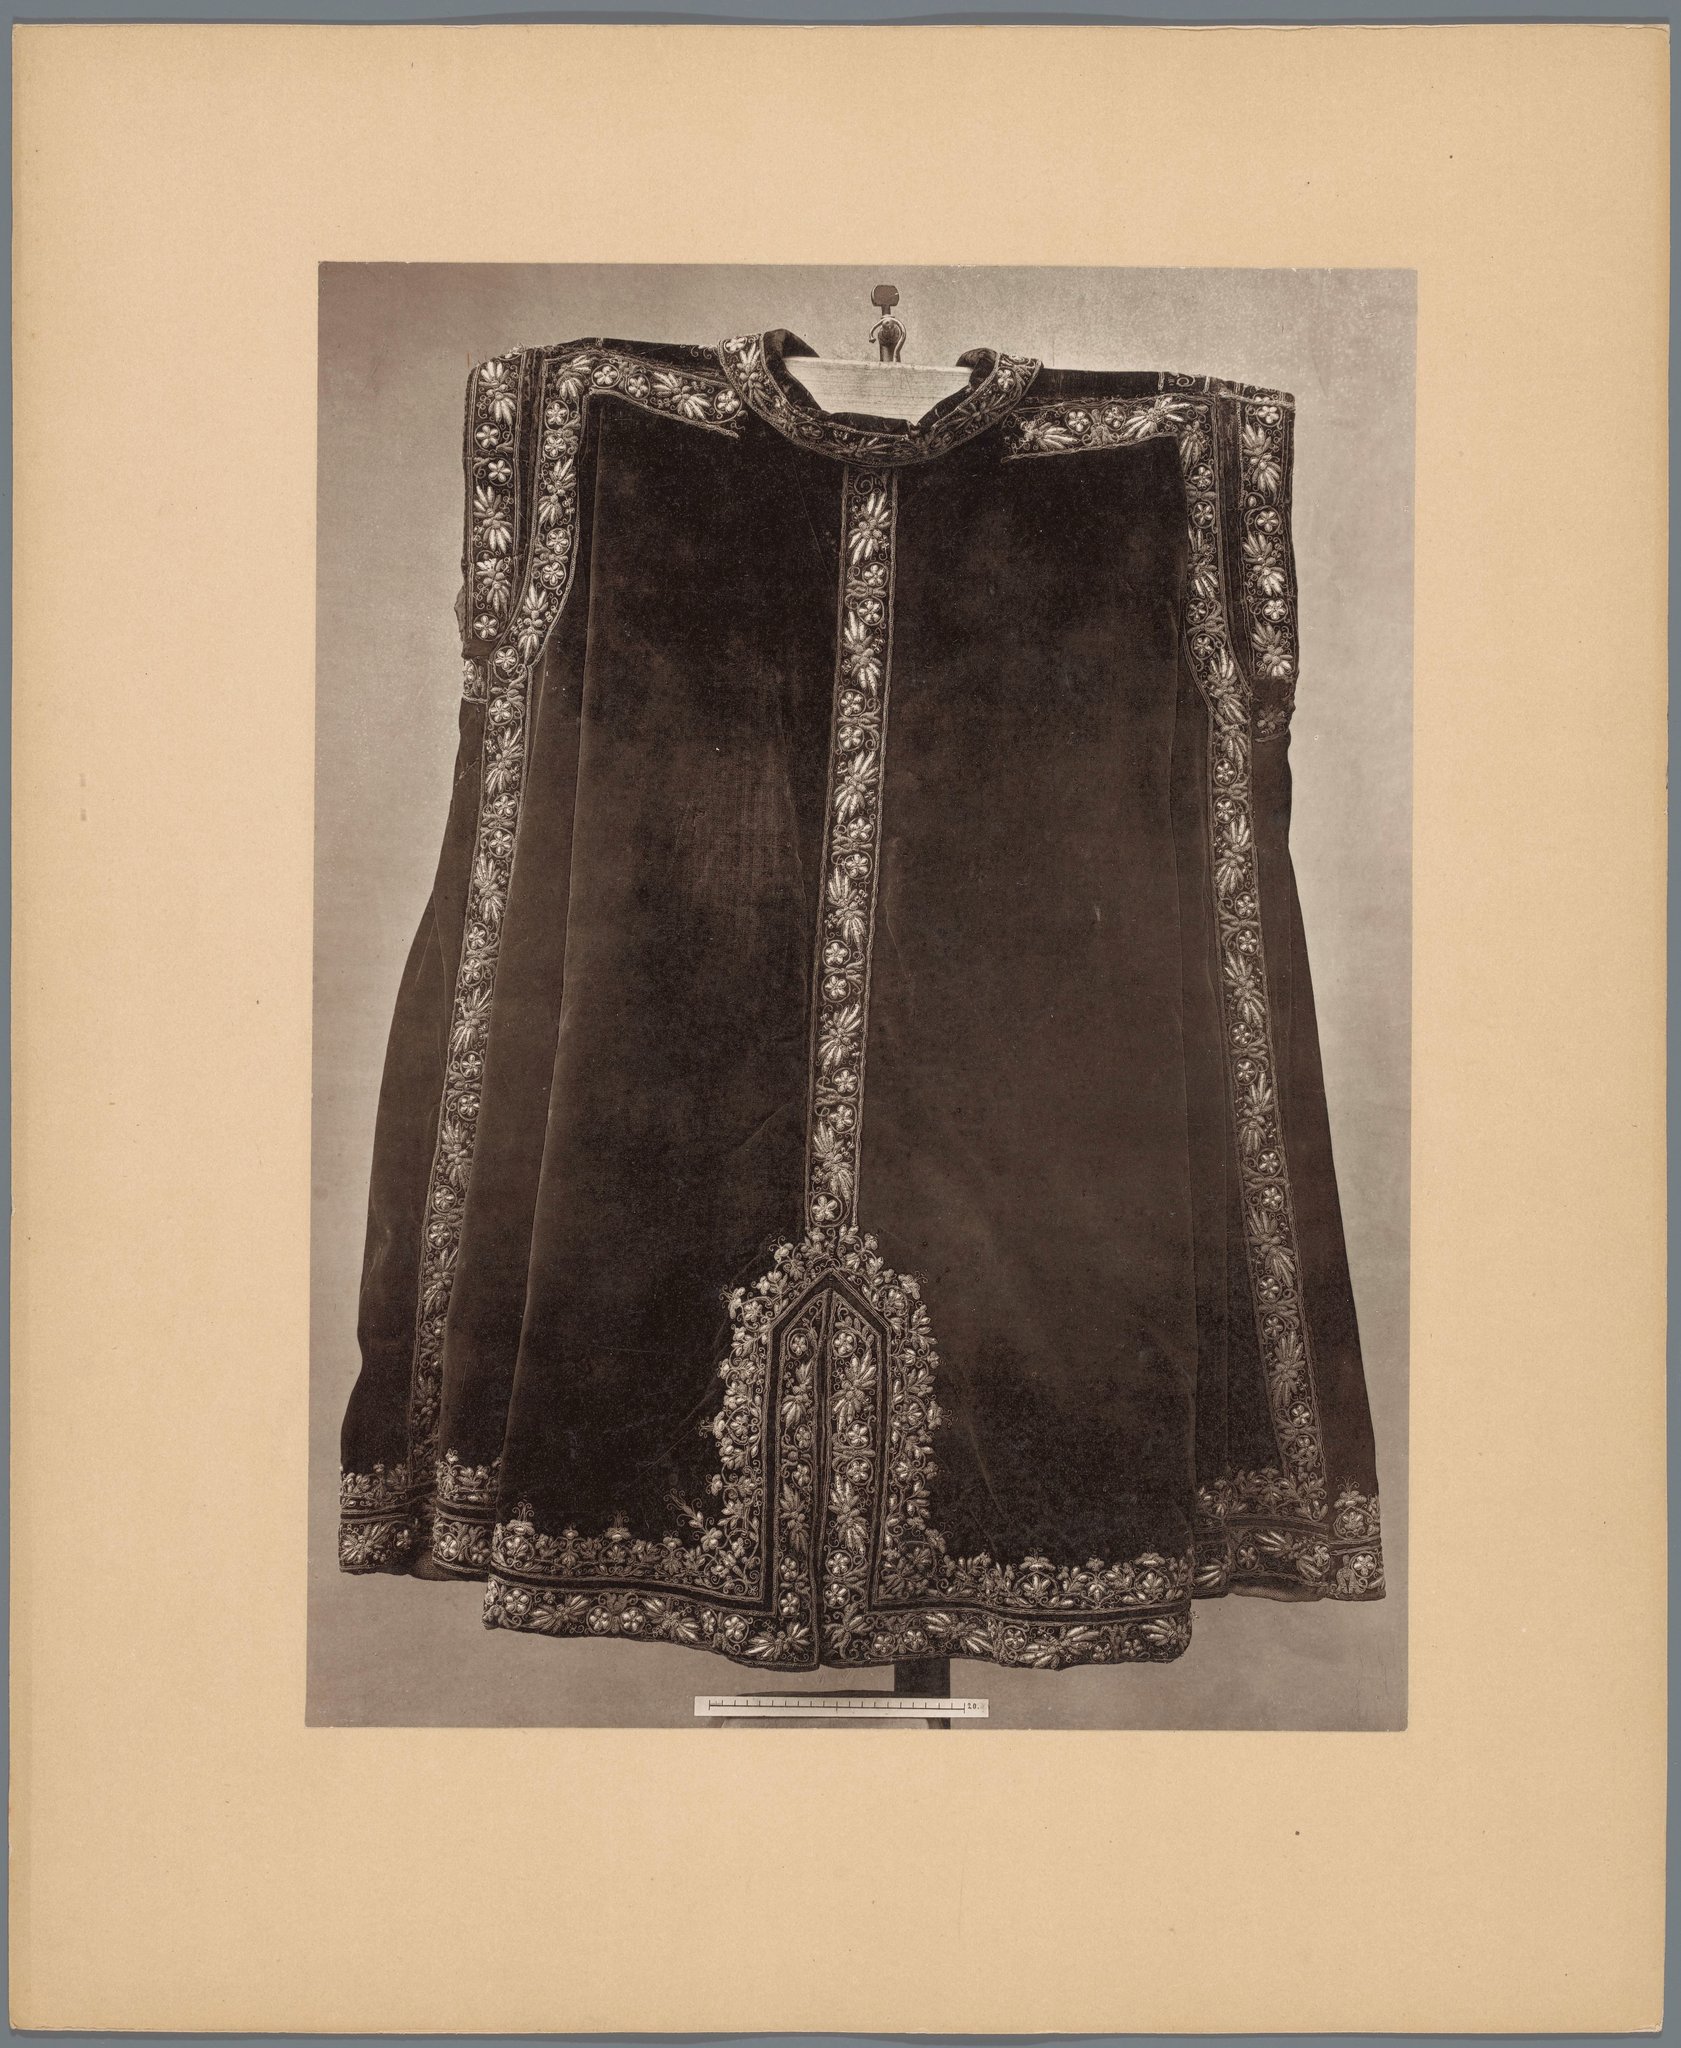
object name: photograph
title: Kazuifel gedecoreerd met bloemmotieven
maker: Anonymous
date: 1875-1900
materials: cardboard, paper, ink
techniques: photograph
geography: europe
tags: chasuble, flowers ~ ornament, europe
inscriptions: collector's mark: Lugt 3937